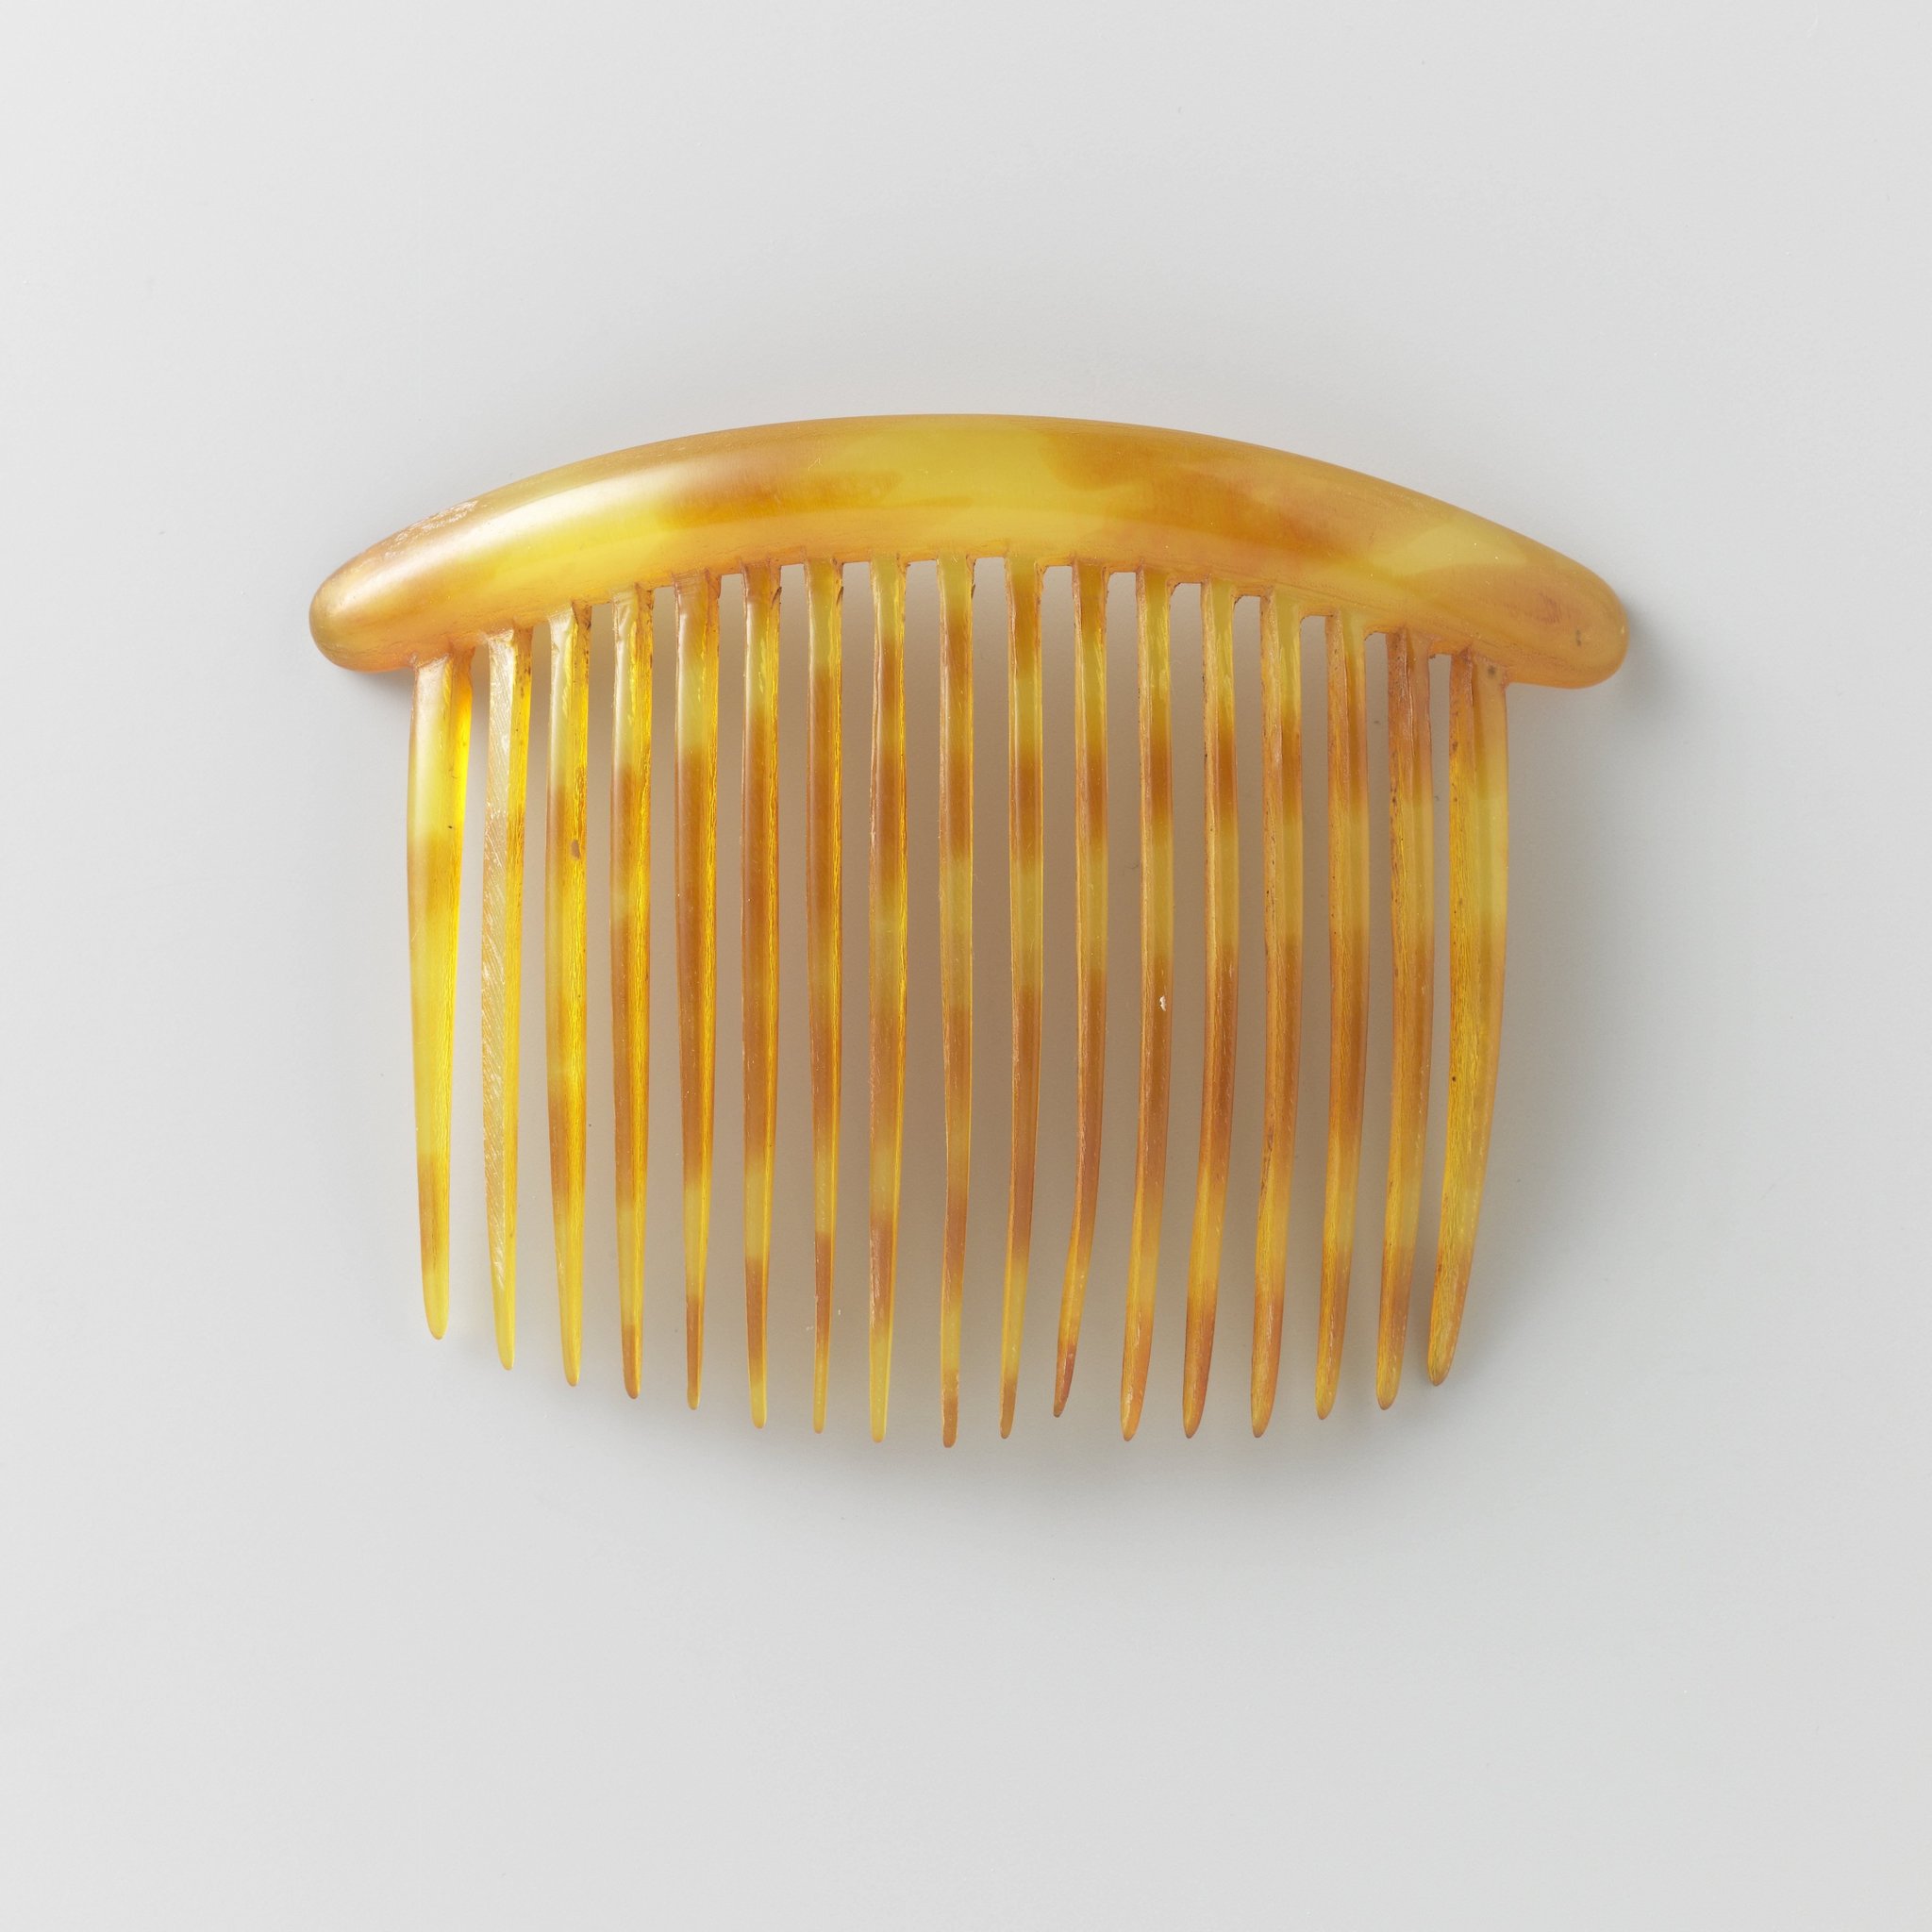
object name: comb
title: Haarkam van blonde imitatie schildpad met effen smalle licht gebogen rug, zeventien tanden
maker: Anonymous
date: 1800-1825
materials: celluloid, plastic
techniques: filing, polish, pressing, sawing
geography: netherlands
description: Haarkam van blonde imitatie schildpad met effen smalle licht gebogen rug. Zeventien tanden.